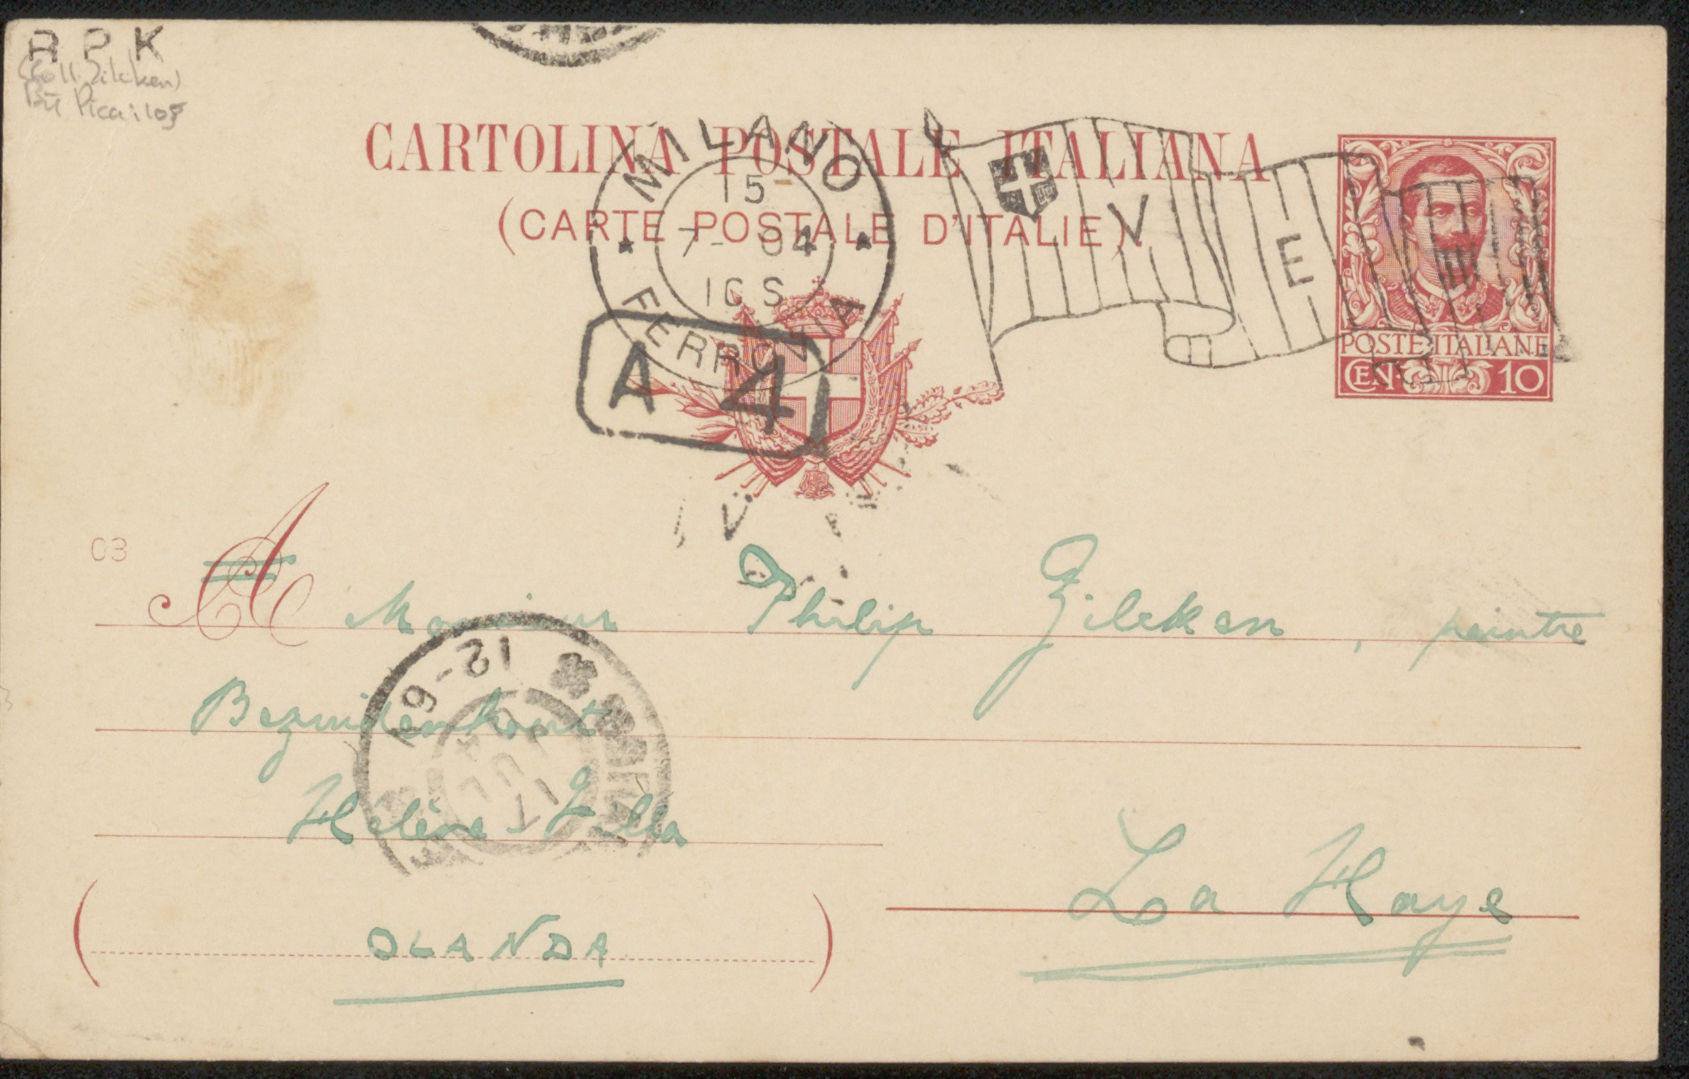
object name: postcard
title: Briefkaart aan Philip Zilcken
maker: vittorio pica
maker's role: criticus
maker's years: 1864-1930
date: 1904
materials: cardboard, ink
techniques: pen, writing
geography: milan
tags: the hague, painter, draughtsman, philip zilcken, printed matter, naples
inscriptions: collector's mark: ‘RPK’